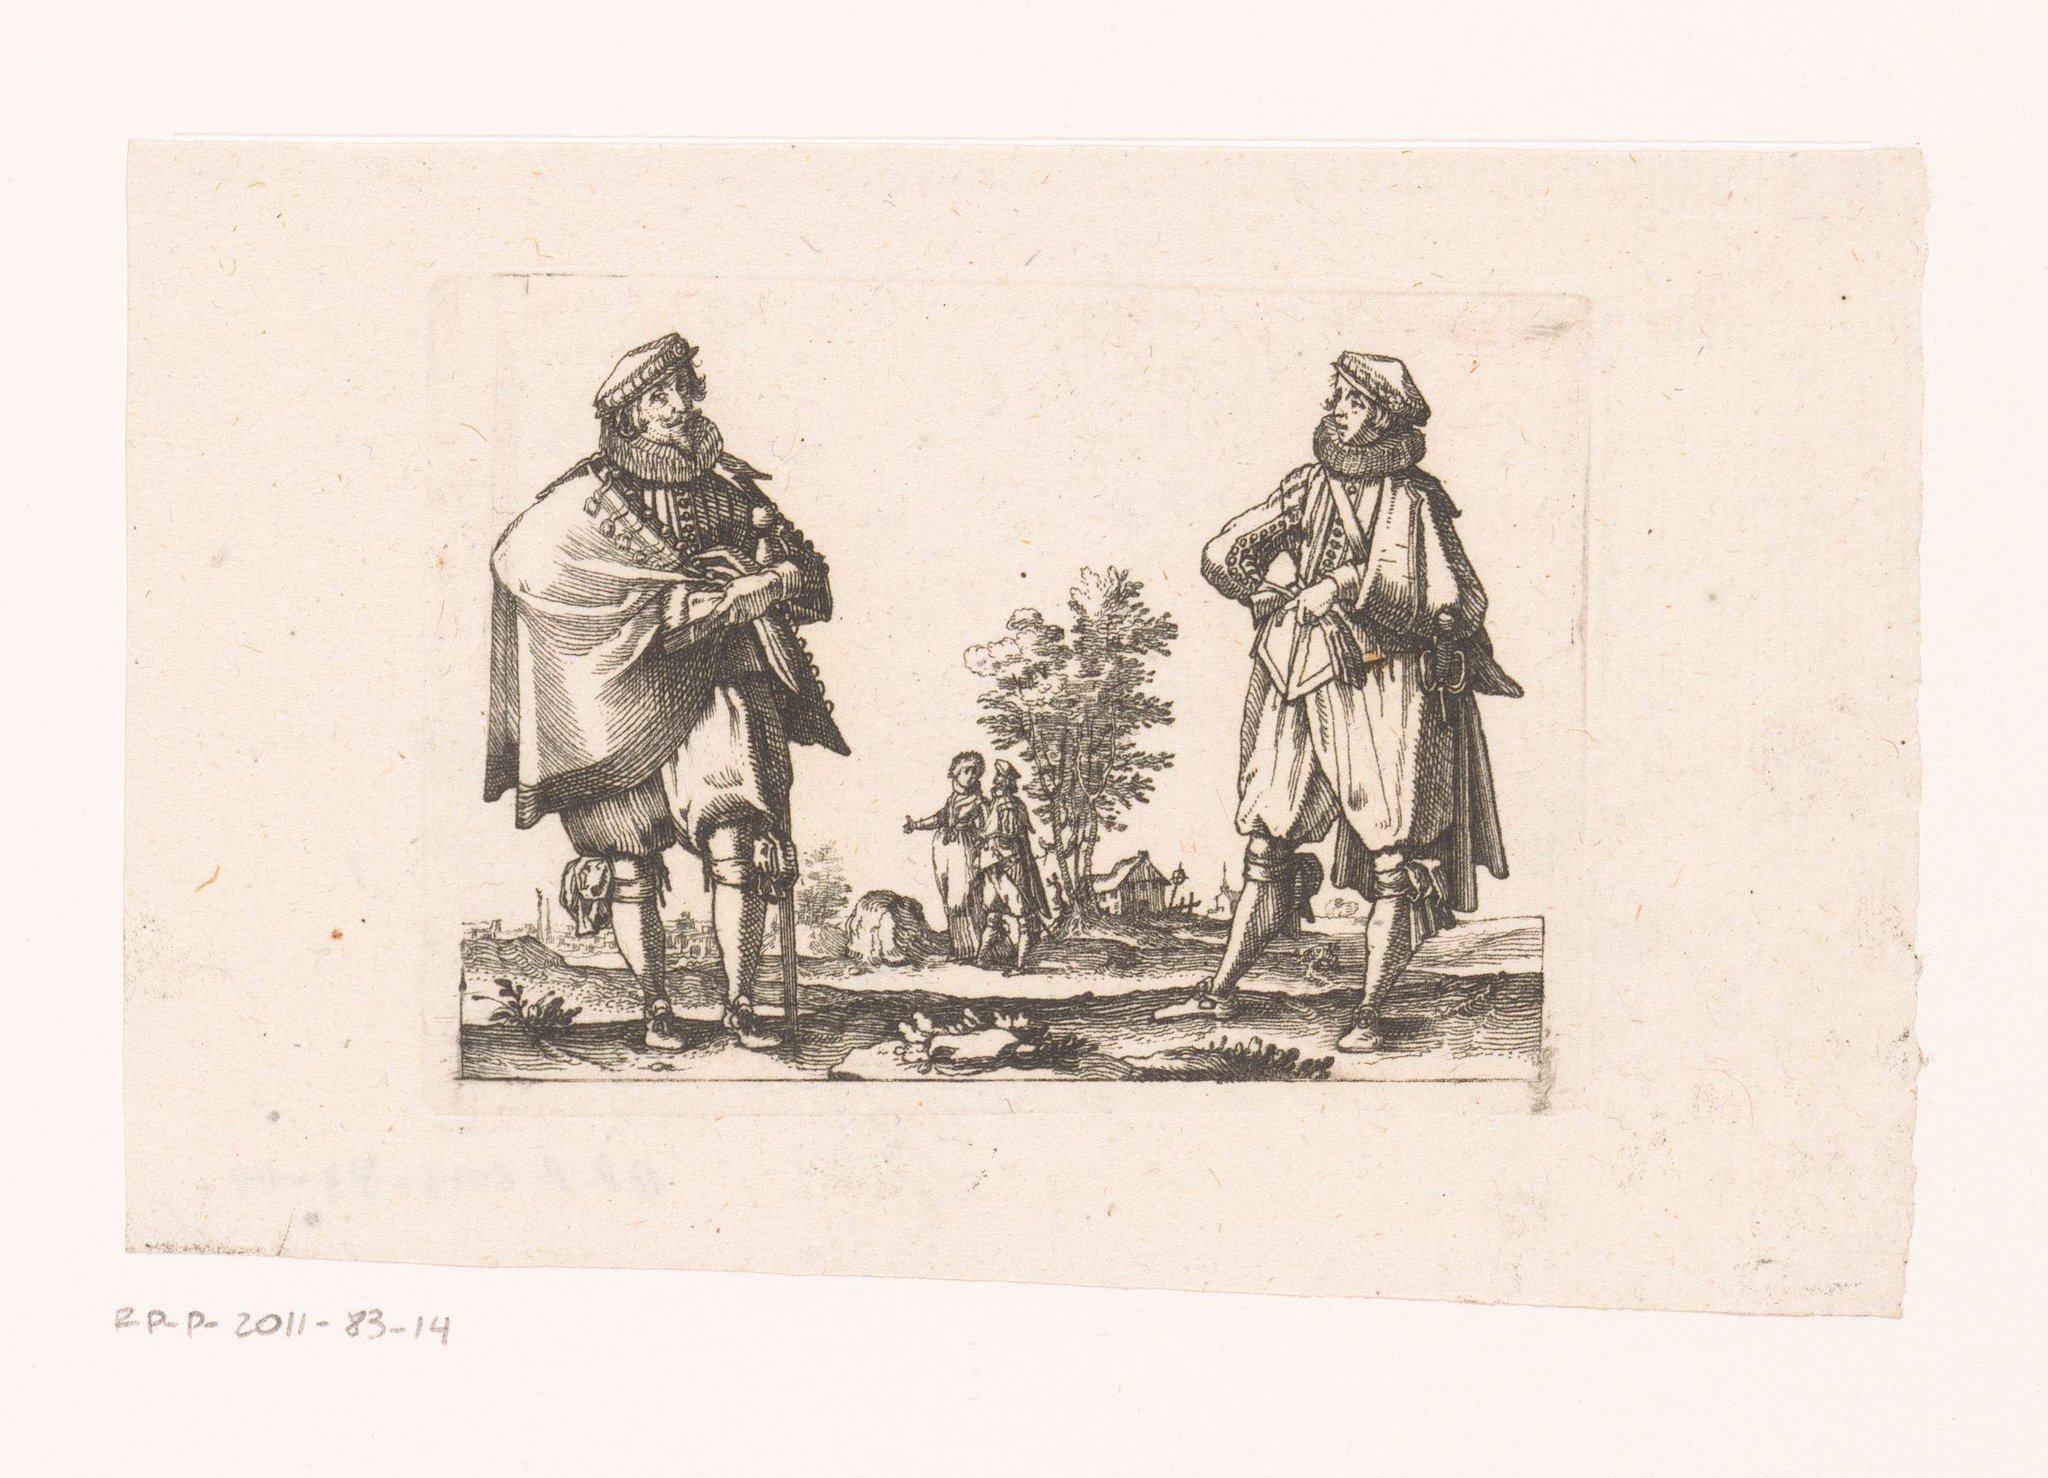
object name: print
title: Soldaten en edelmannen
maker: rudolph meyer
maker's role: print maker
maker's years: 1605-1638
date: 1615-1638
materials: paper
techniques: etching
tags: the soldier; the soldier's life, couple of lovers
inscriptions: collector's mark, collector's mark: Lugt 2228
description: Onderdeel van een serie van zestien voorstellingen van soldaten (Soldatenbüchli).